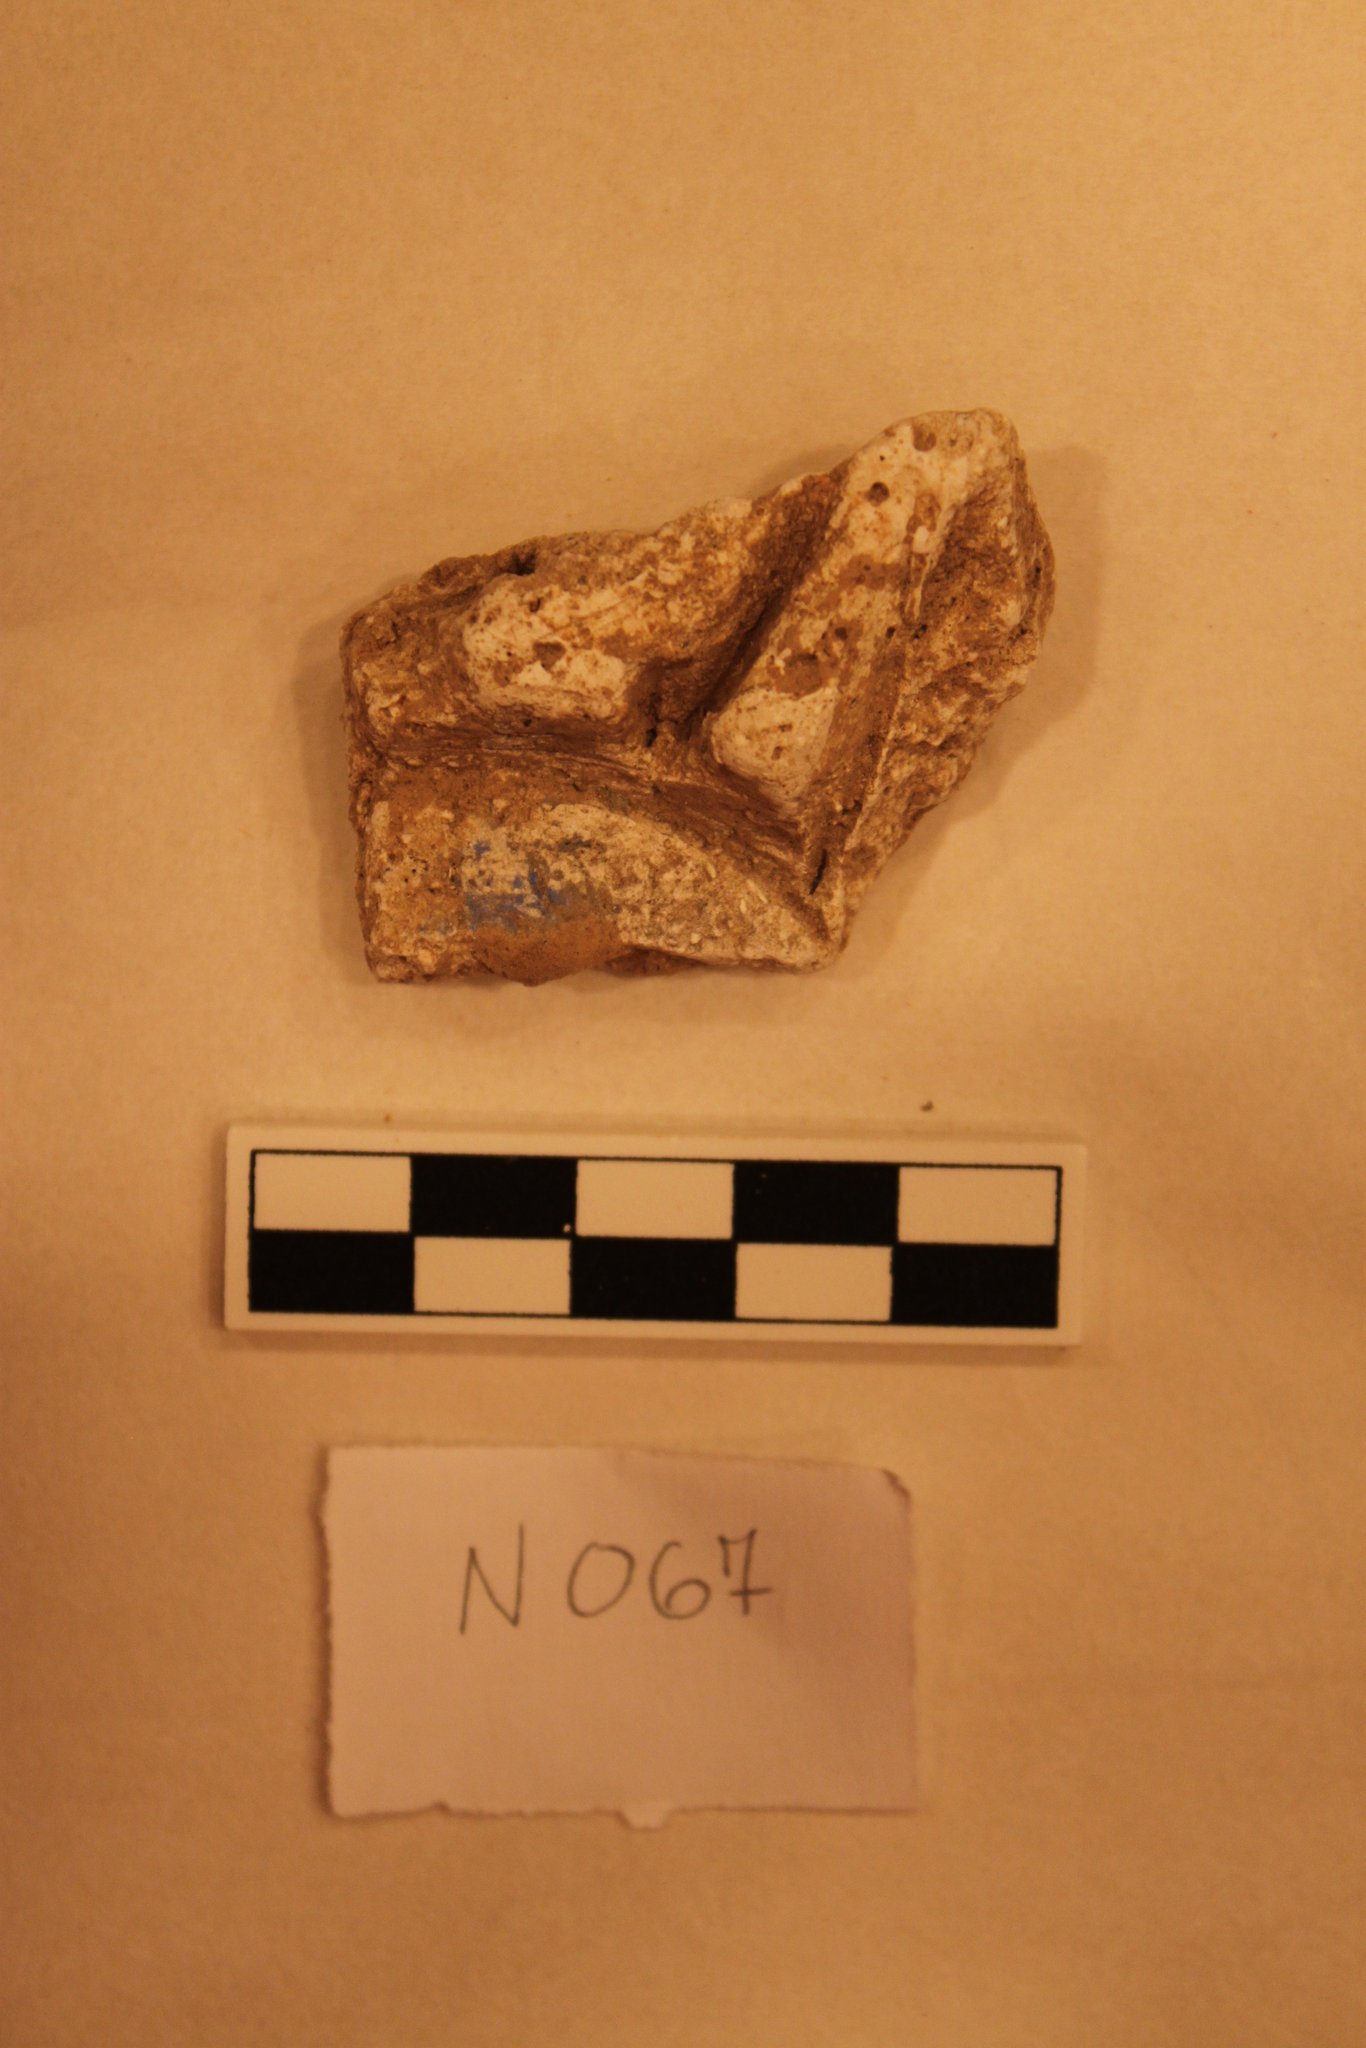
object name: fragment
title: Stucco Fragment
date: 701-1200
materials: plaster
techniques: carving, painting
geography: iran